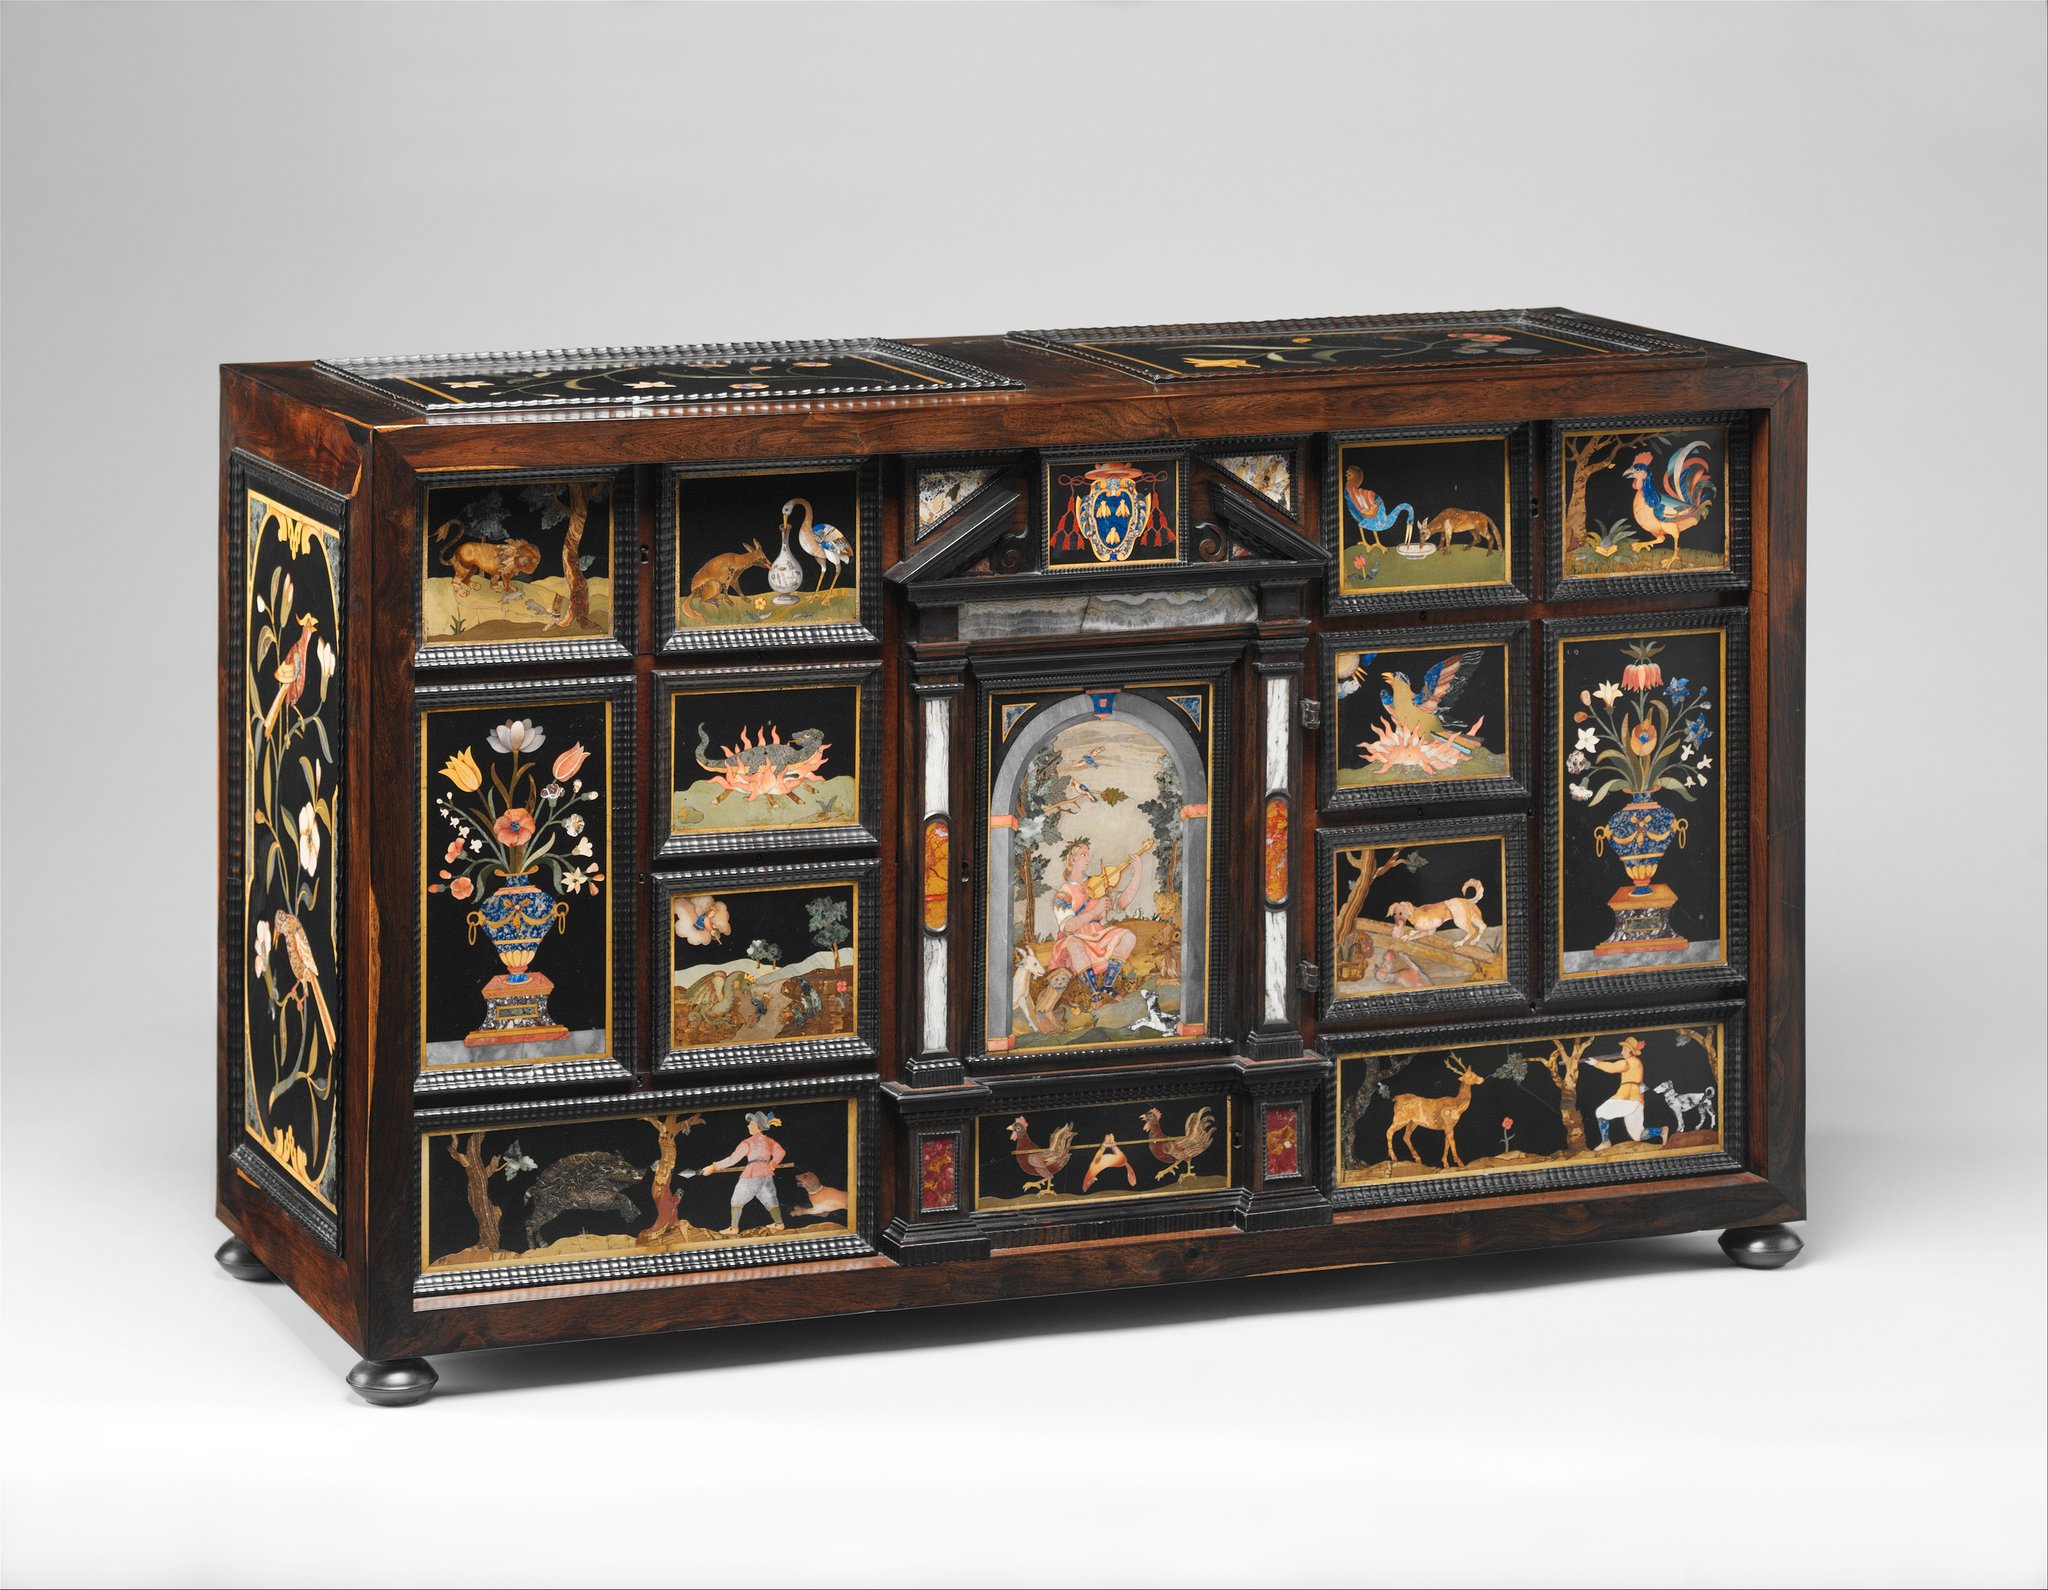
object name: cabinet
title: Barberini Cabinet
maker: galleria dei lavori, florence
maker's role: maker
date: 1606-1623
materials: wood, marble, quartz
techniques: veneering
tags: birds,men,hunting,roosters,boars,deer,dogs,foxes,lions,flowers,salamanders